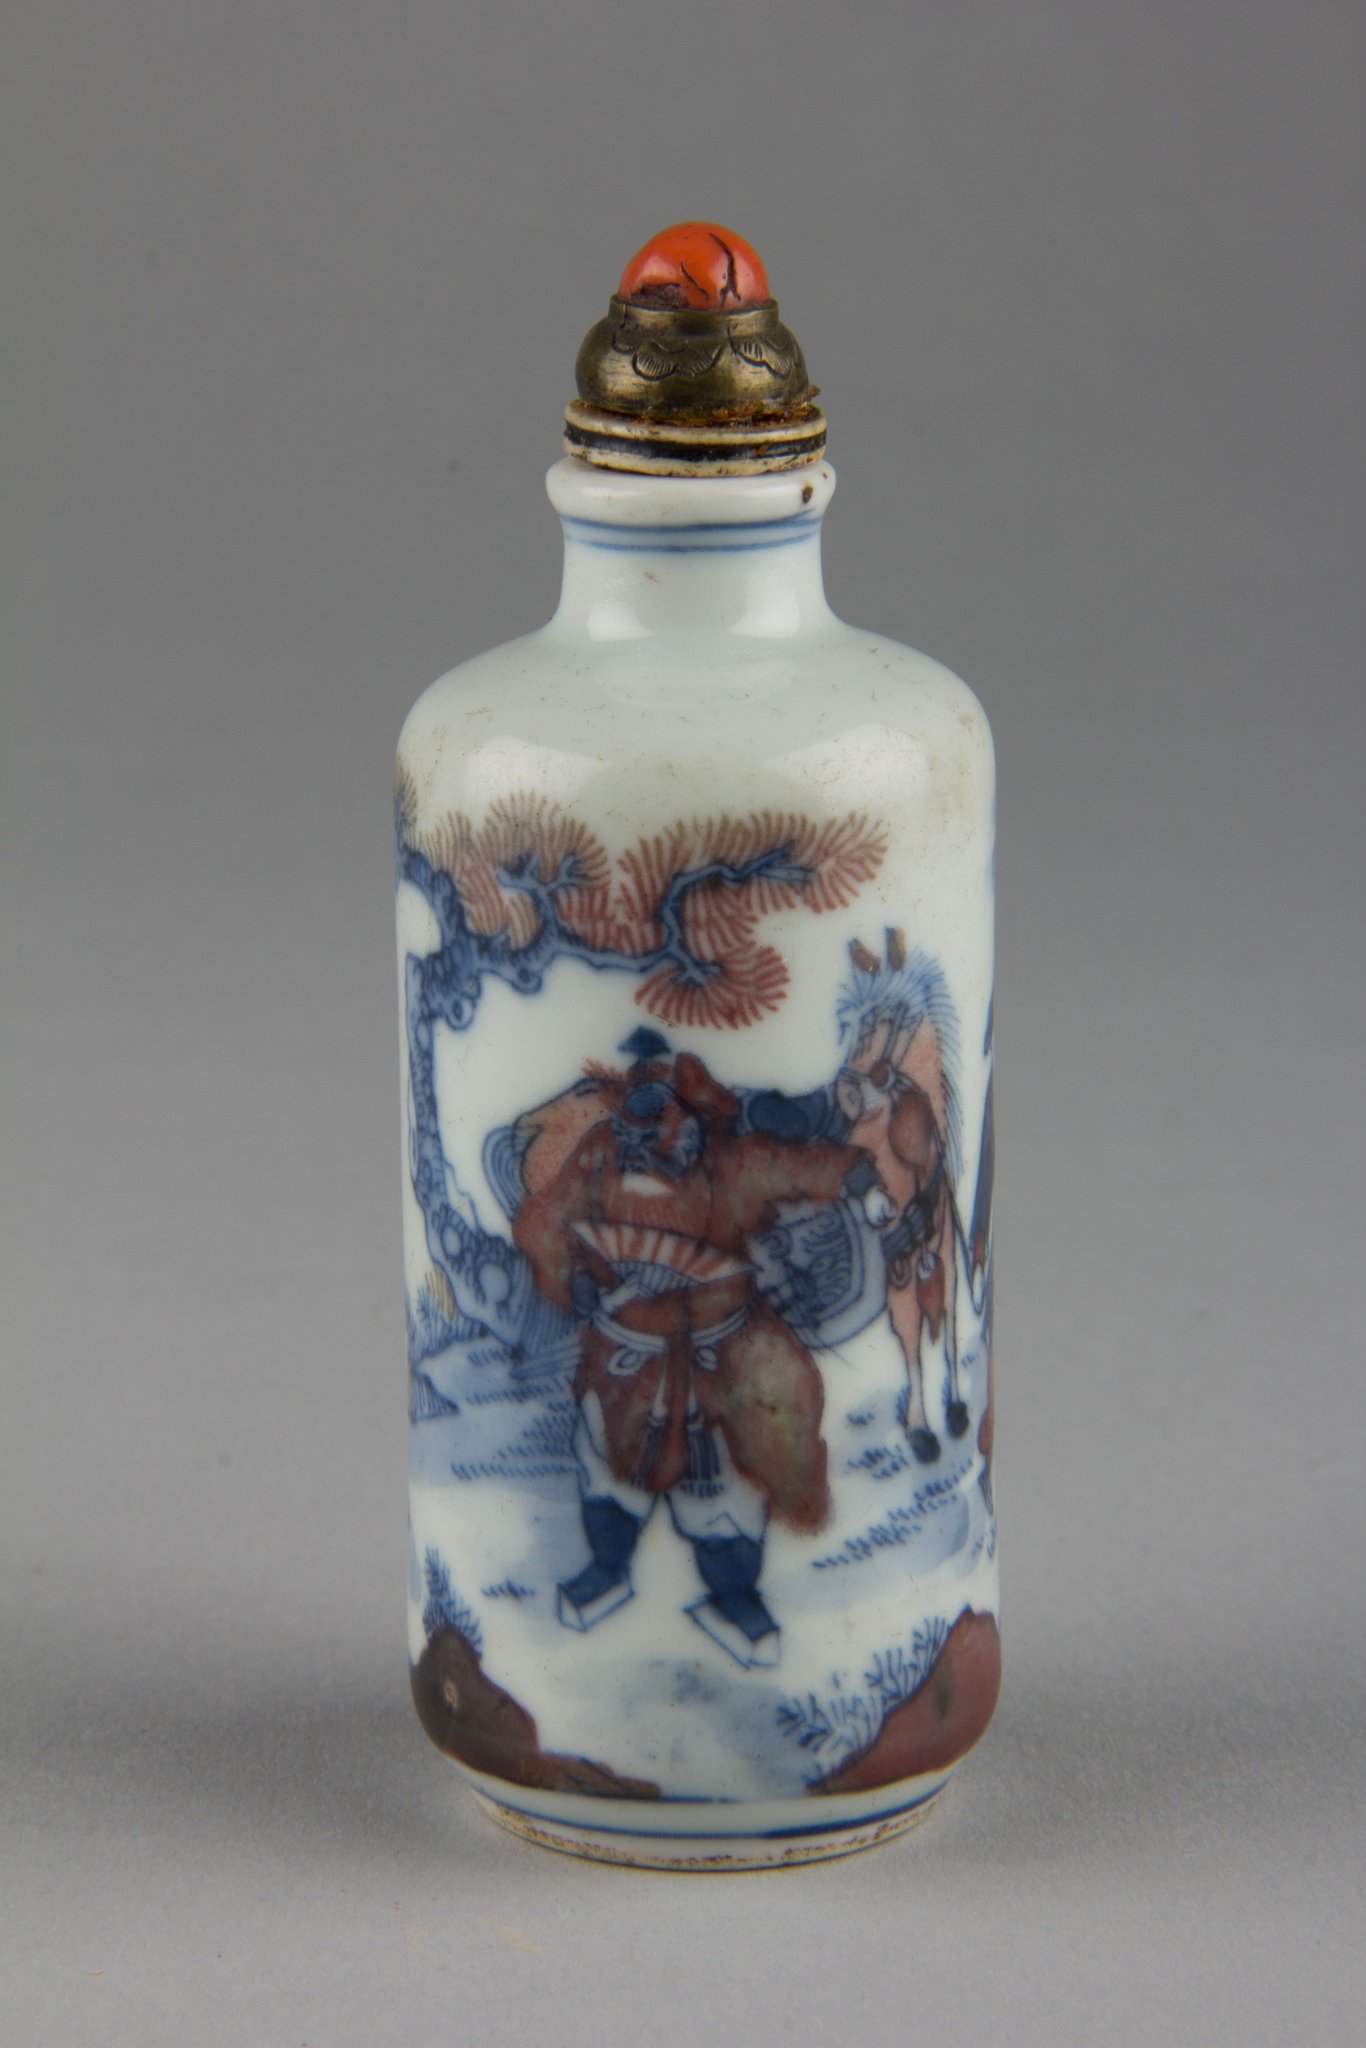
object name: snuff bottle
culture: chinese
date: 1723-1735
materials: porcelain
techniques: underglaze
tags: men,horses